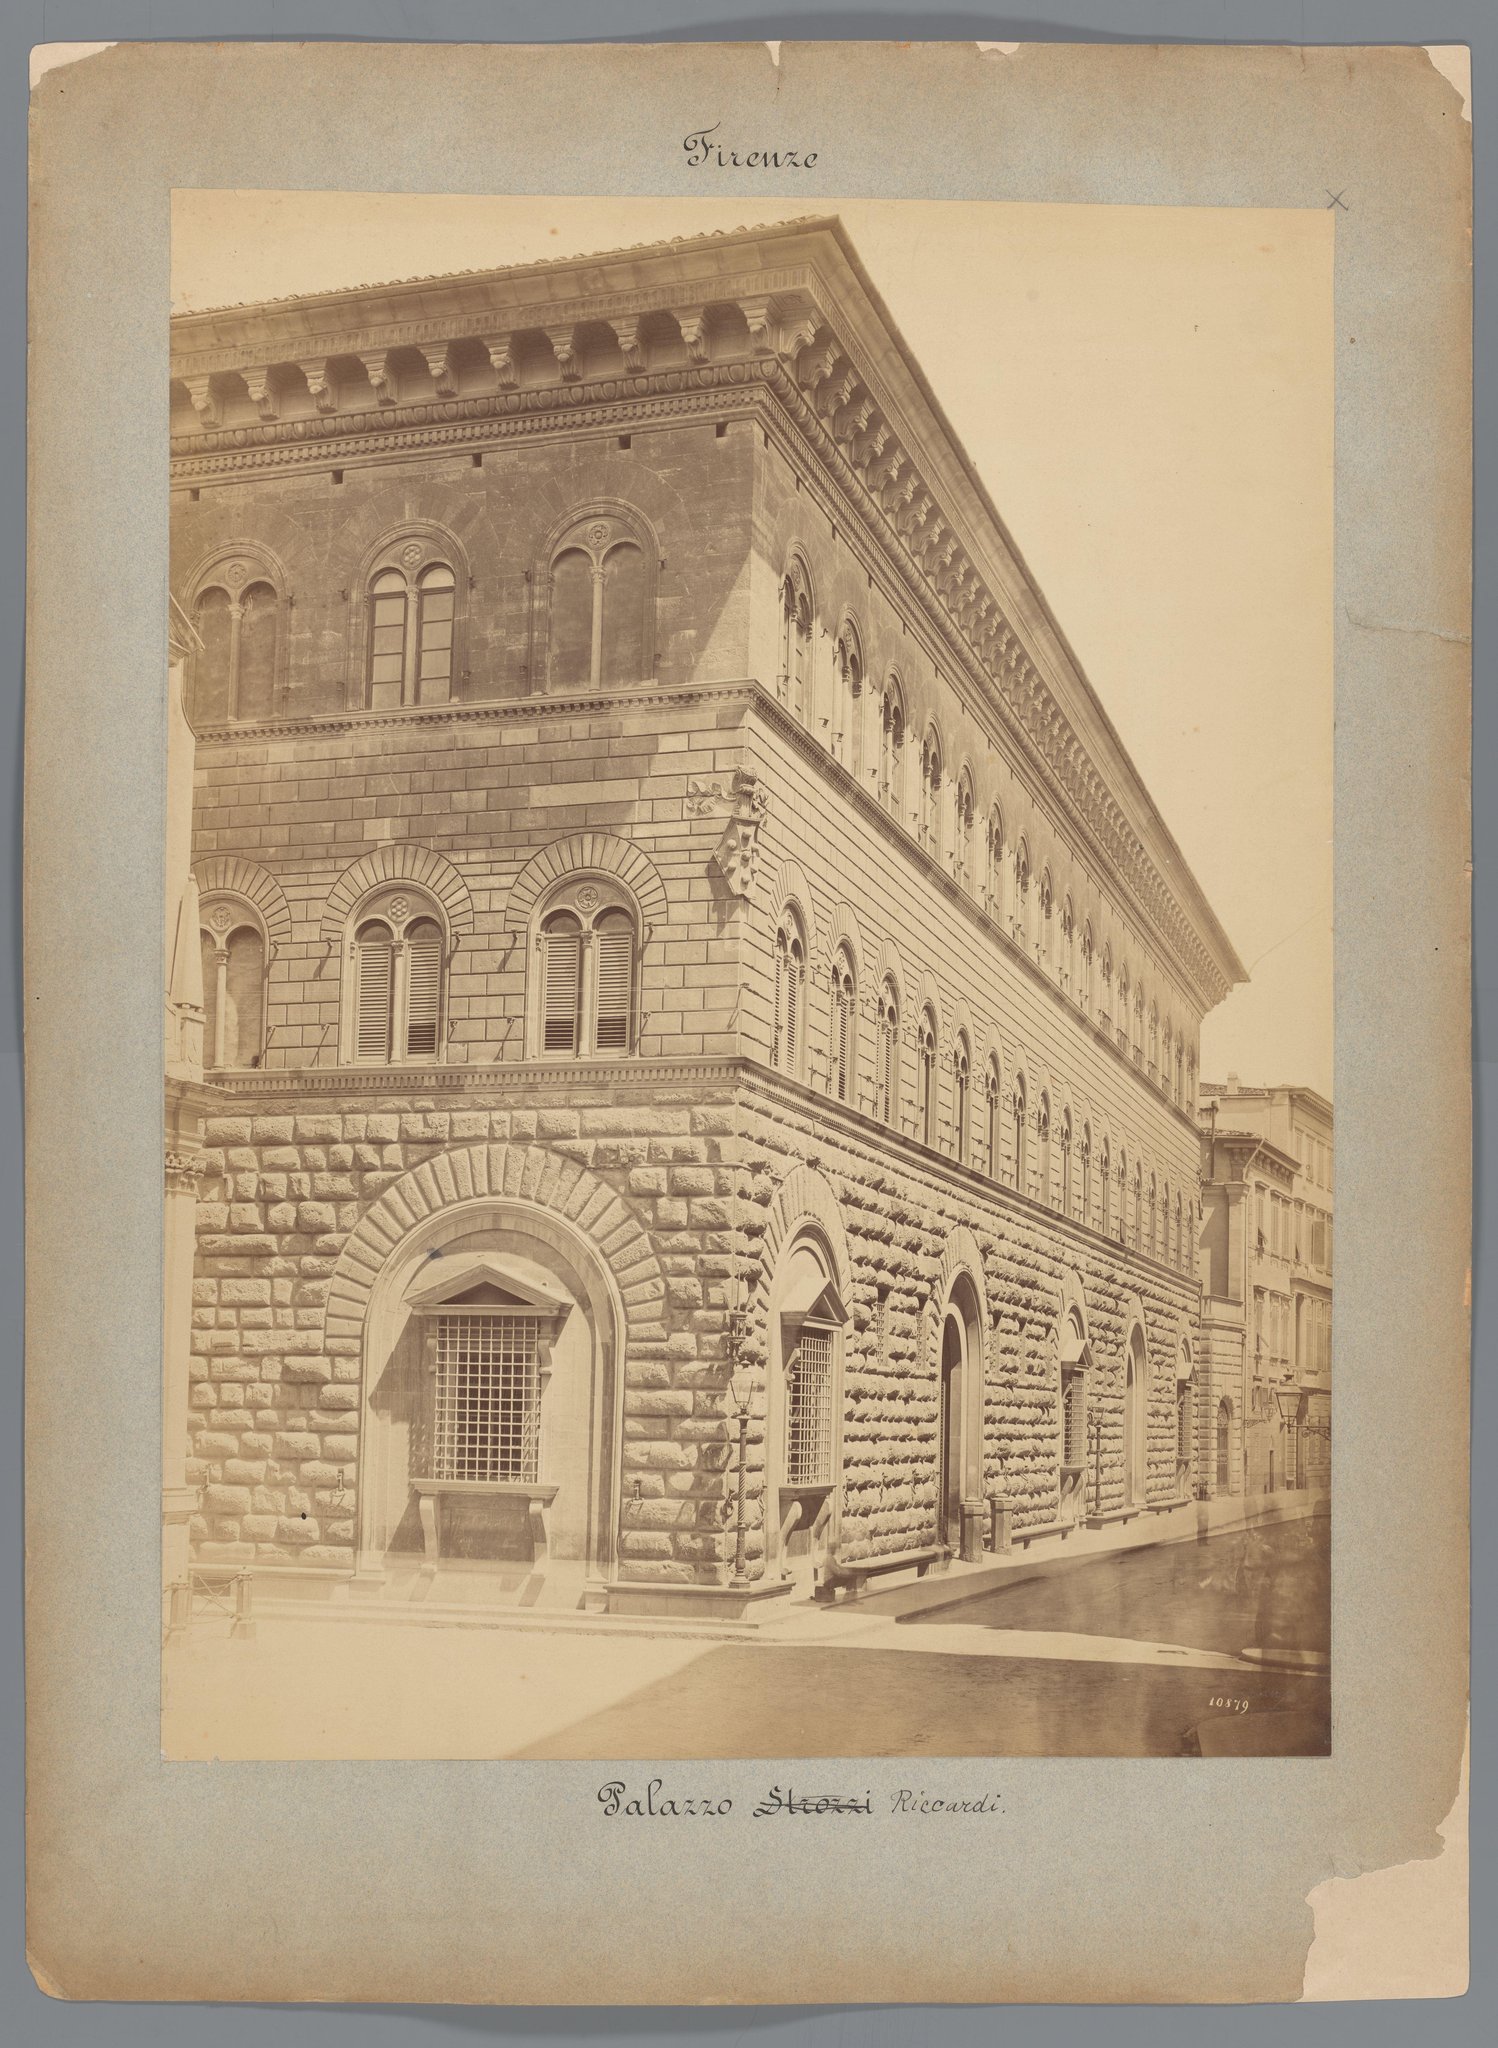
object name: photograph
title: Gezicht op het Palazzo Riccardi te Florence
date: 1865-1900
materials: cardboard, photographic support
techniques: albumen print, calligraphy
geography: florence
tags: palazzo riccardi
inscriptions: : ‘10789’, signature: ‘FRATELLI ALINARI’, : ‘Firenze / Palazzo Riccardi’